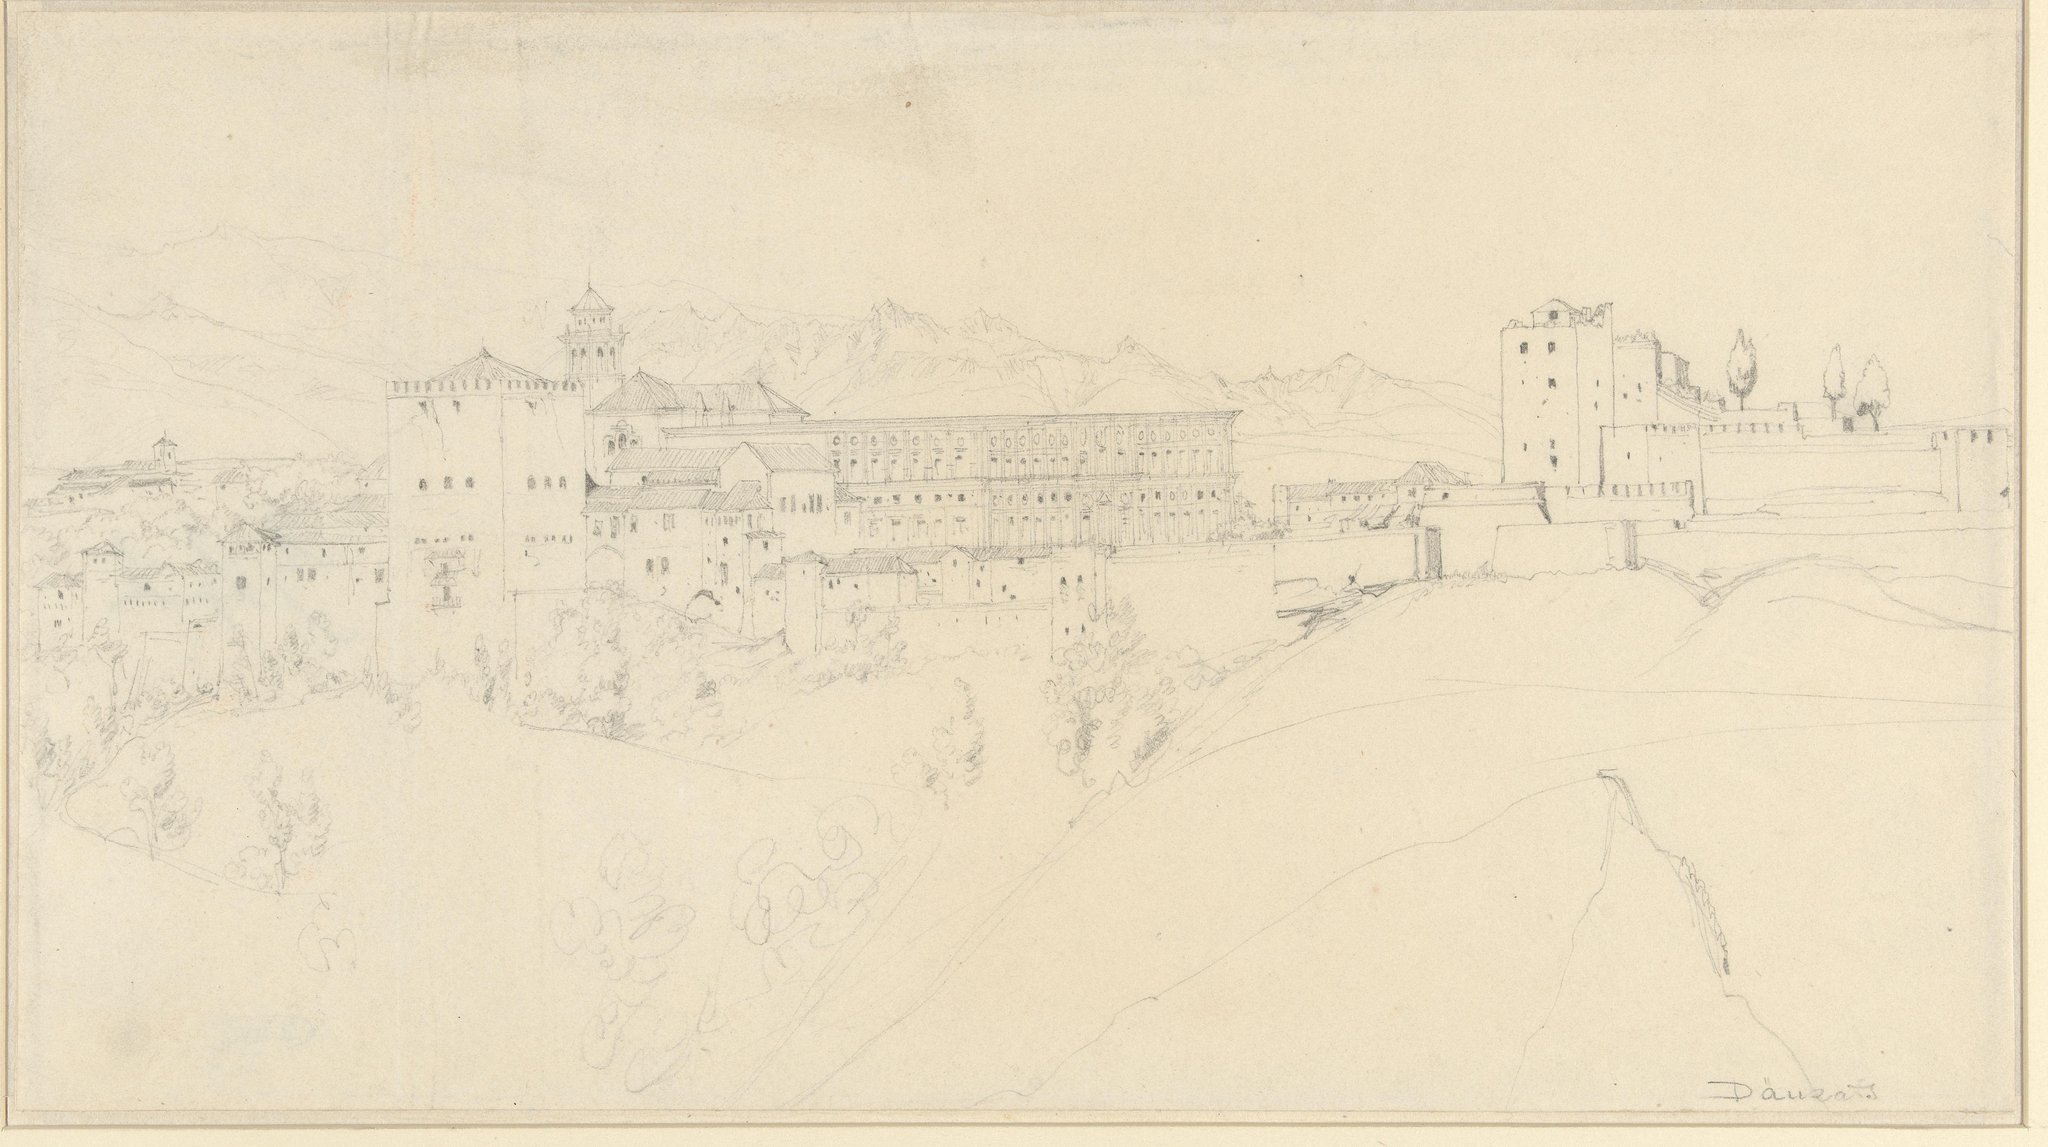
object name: drawing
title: Gezicht op een hooggelegen Italiaanse of Spaanse stad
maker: adrien dauzats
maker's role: draughtsman, print maker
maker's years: 1804-1868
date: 1814-1868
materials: paper, pencil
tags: city-view in general; 'veduta'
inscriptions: signature: ‘Dauzats’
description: Gezicht op een hooggelegen Italiaanse of Spaanse stad met een groot paleisachtig gebouw in de nabijheid van een kerk.